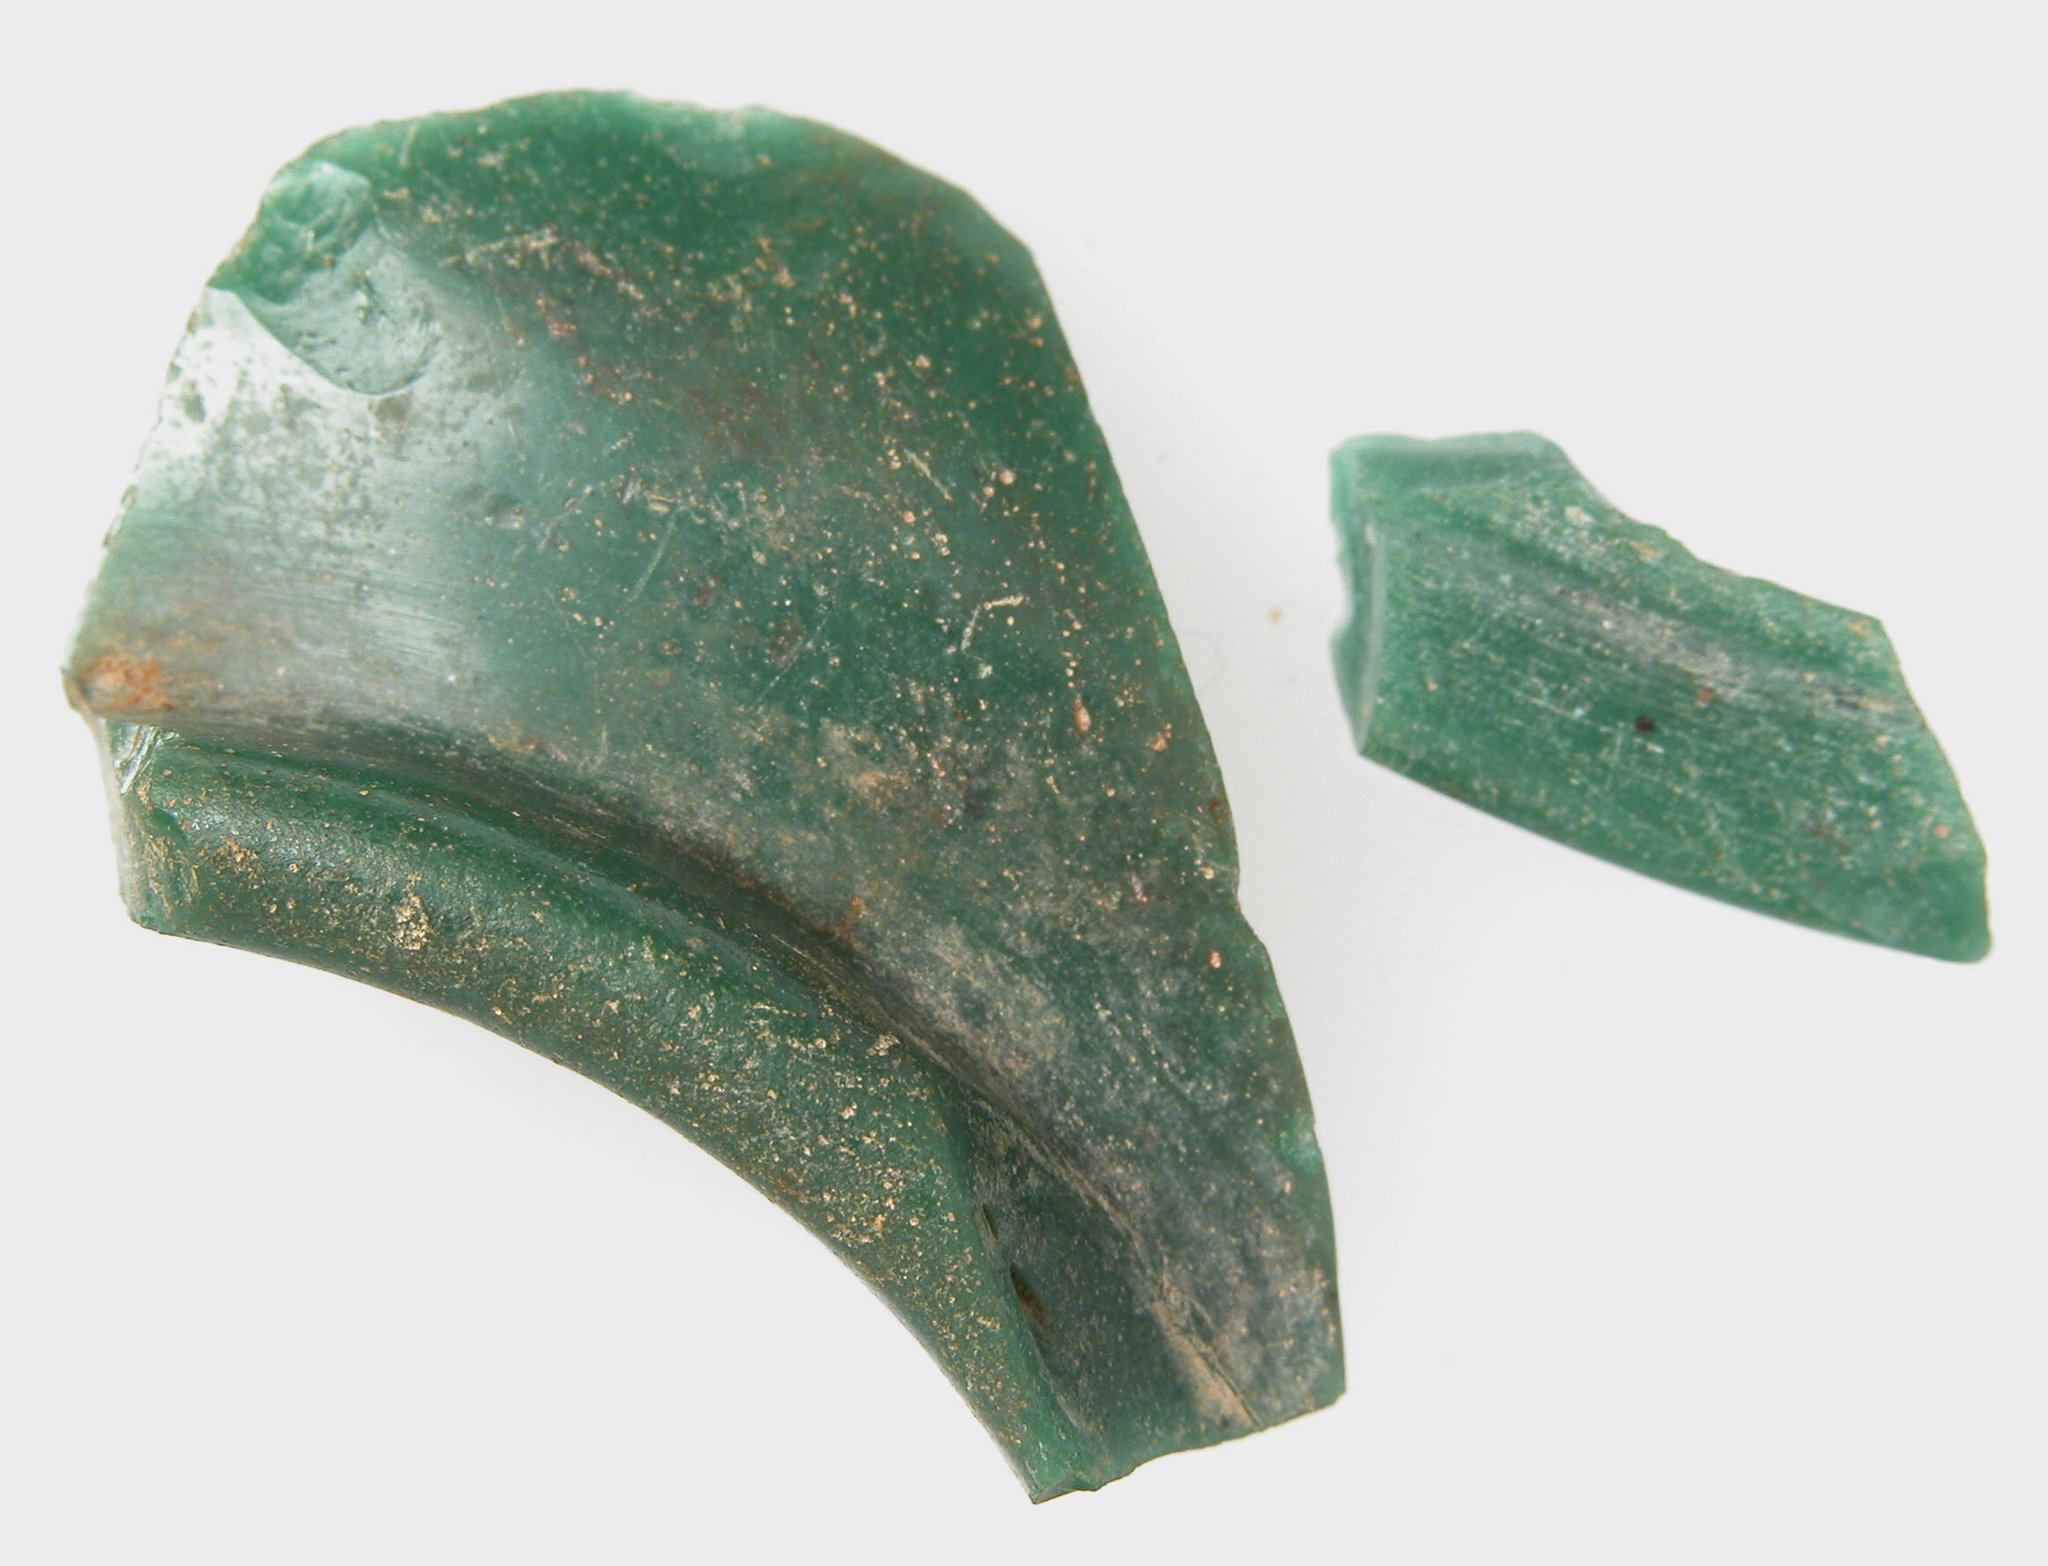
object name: fragment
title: Glass Fragments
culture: coptic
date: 301-433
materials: glass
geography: egypt